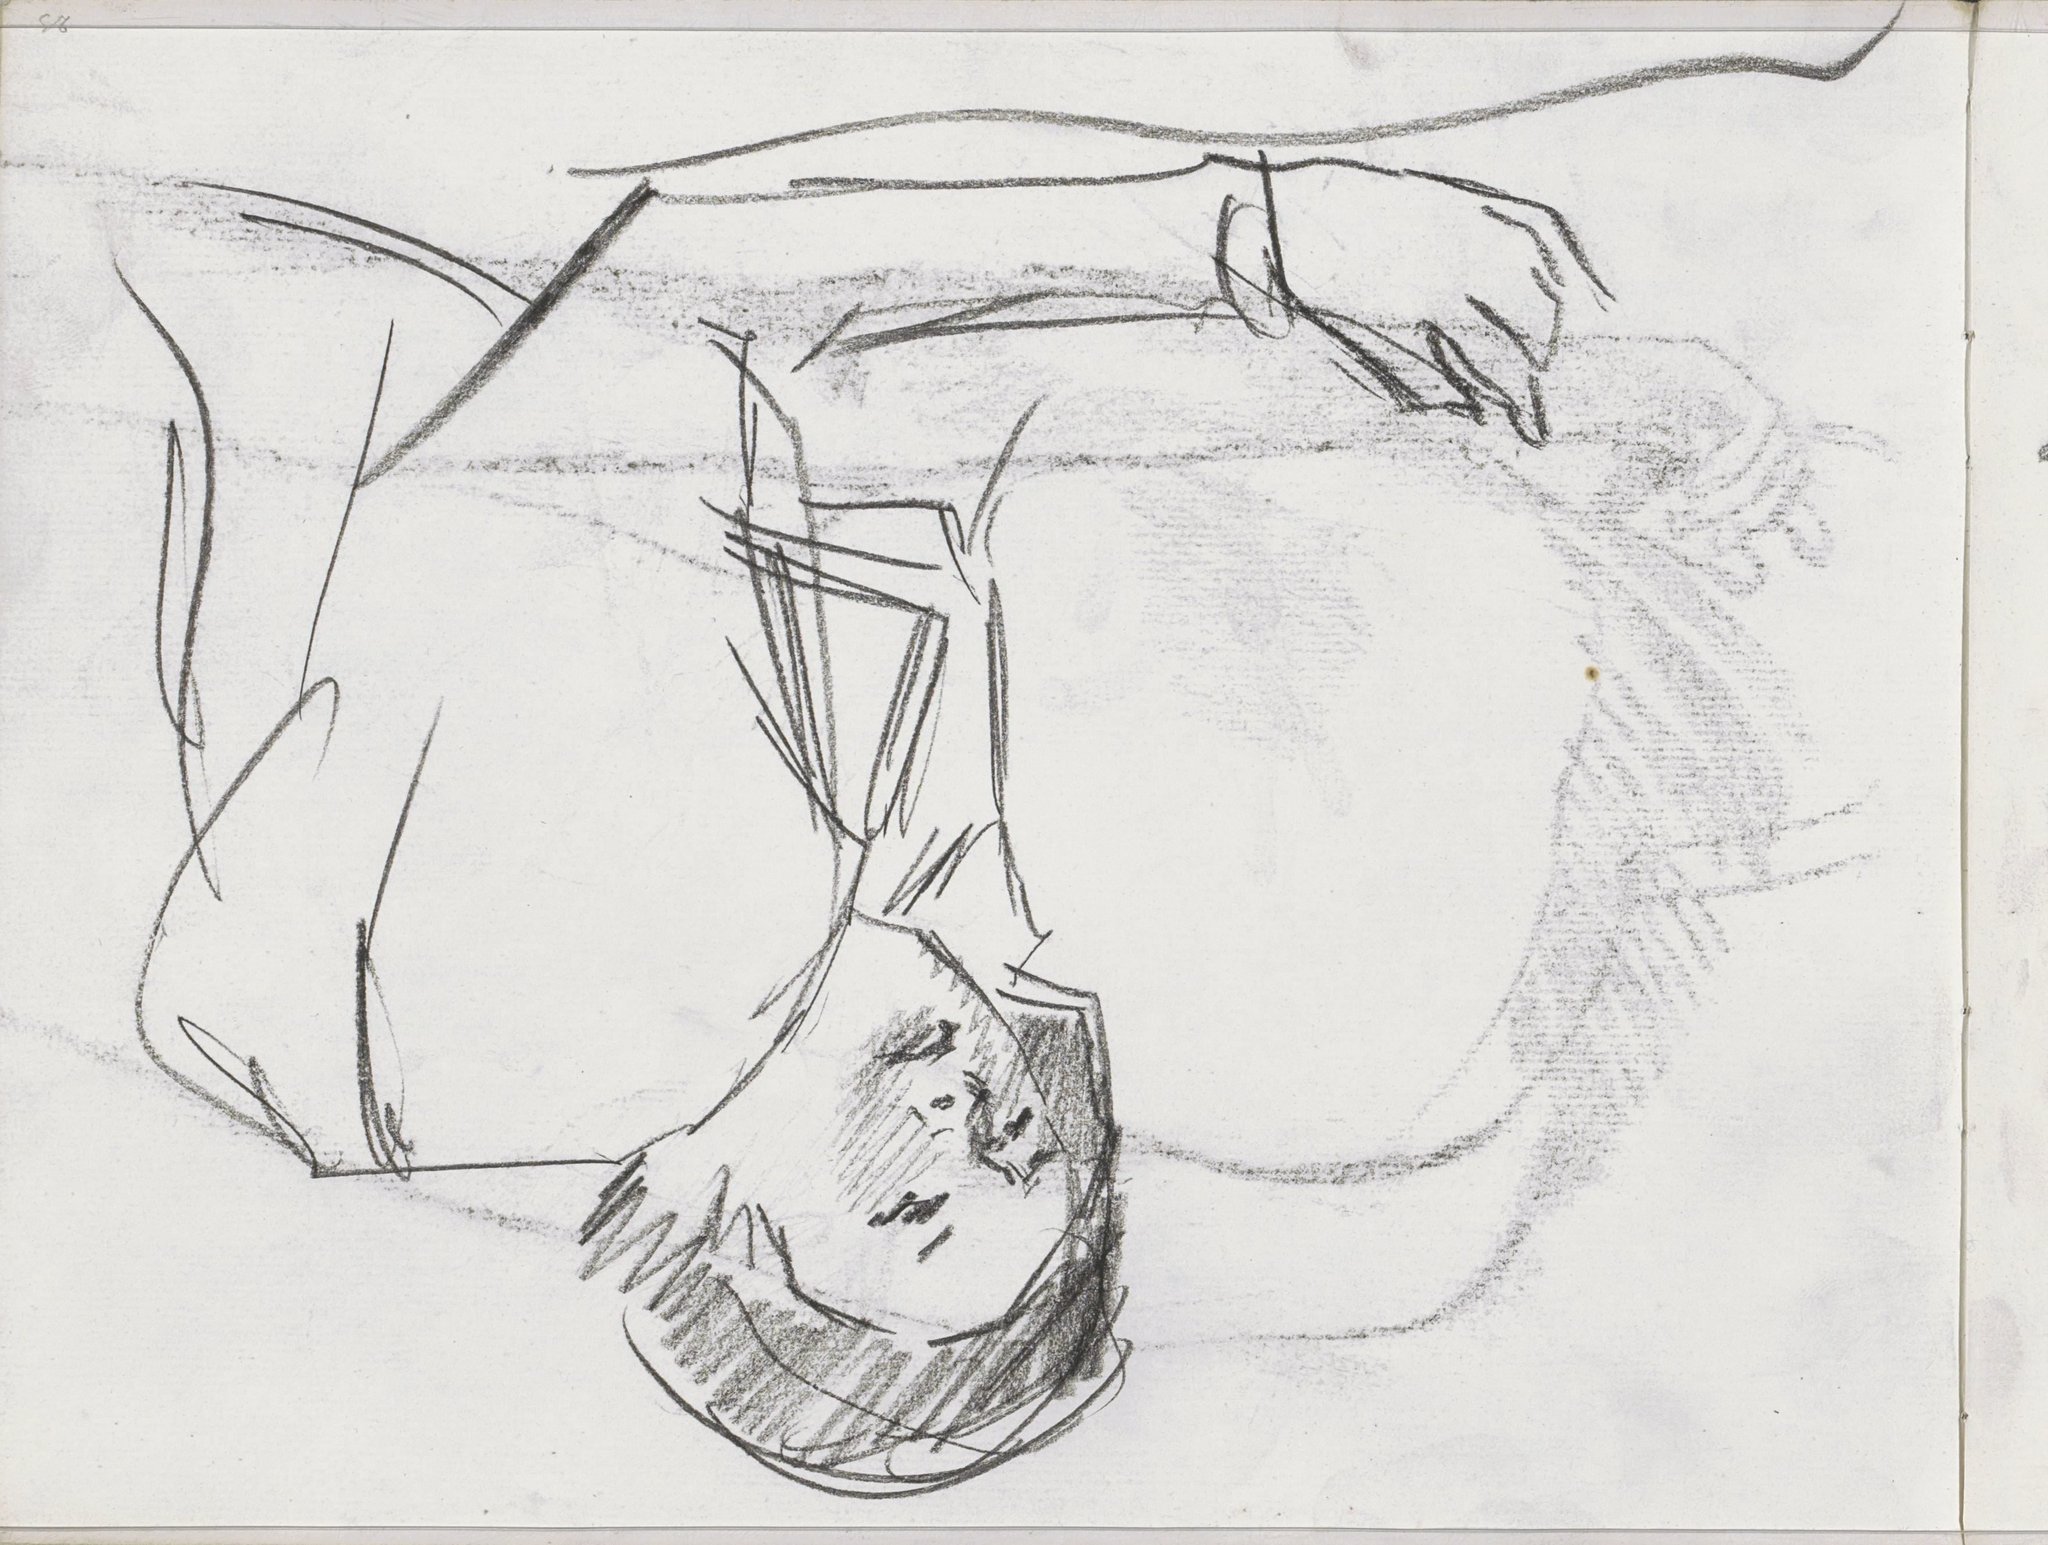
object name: sketchbook leaf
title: Liggende vrouw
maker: isaac israels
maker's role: draughtsman, painter, print maker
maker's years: 1865-1934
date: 1875-1934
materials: chalk, paper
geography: the hague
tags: lying figure - aa - female human figure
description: Blad 12 verso uit schetsboek XIV met 17 bladen.